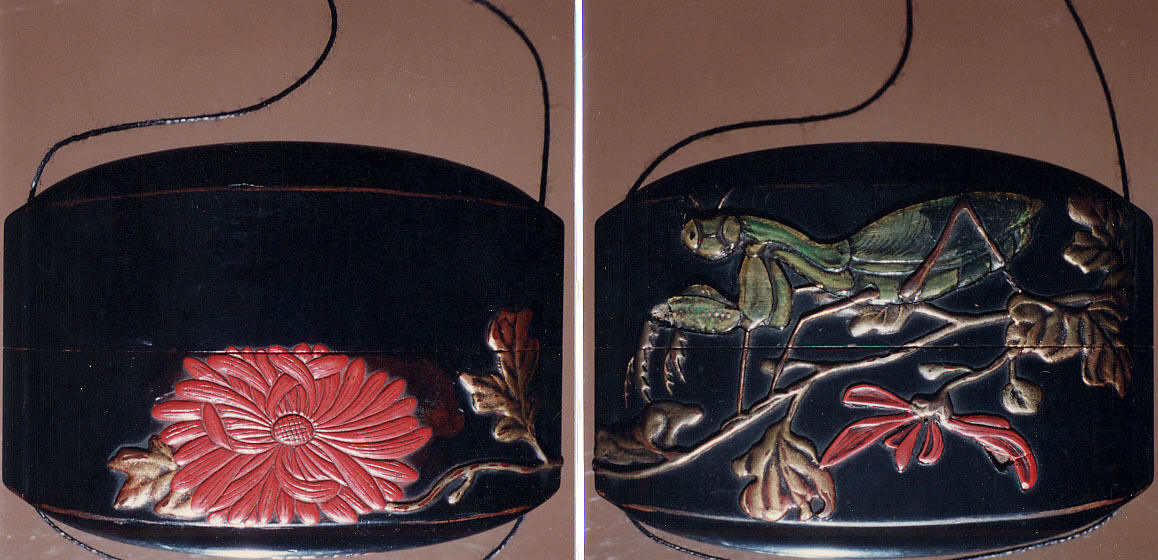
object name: inrō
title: Case (Inrō) with Design of Praying Mantis Standing on a Flowering Chrysanthemum (obverse); Large Red Blossom (reverse)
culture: japanese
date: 1701-1800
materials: ceramic, gold, lacquer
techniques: fundame, hiramakie, inlay, roiro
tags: insects,flowers